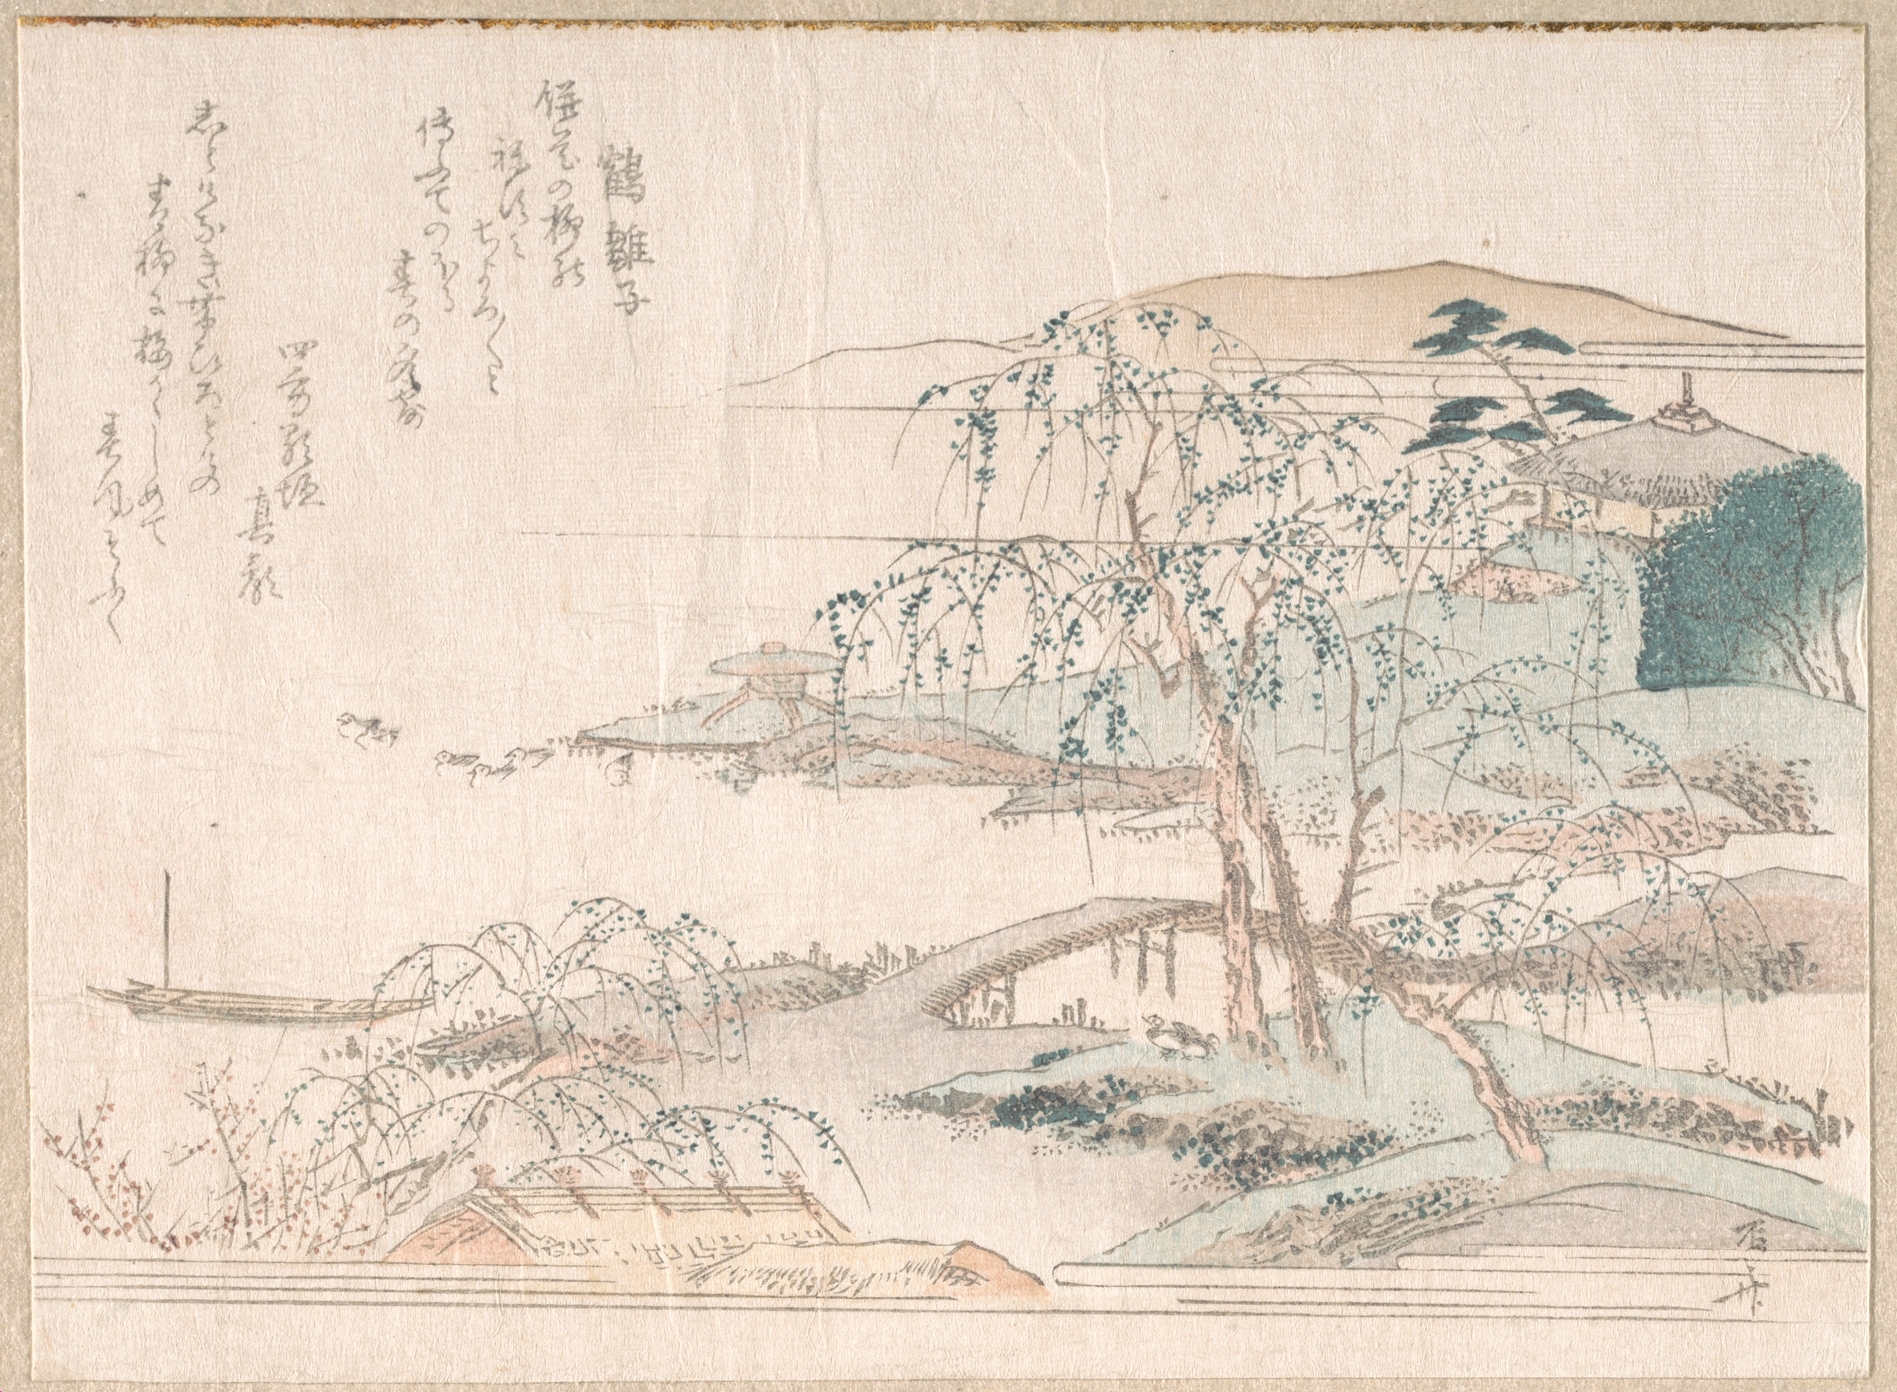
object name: print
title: Landscape with Willow Trees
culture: japanese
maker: ryūryūkyo shinsai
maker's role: artist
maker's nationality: japanese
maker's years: 1799-1823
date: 1801-1900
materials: ink, paper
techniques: surimono, woodblock print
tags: landscapes,trees